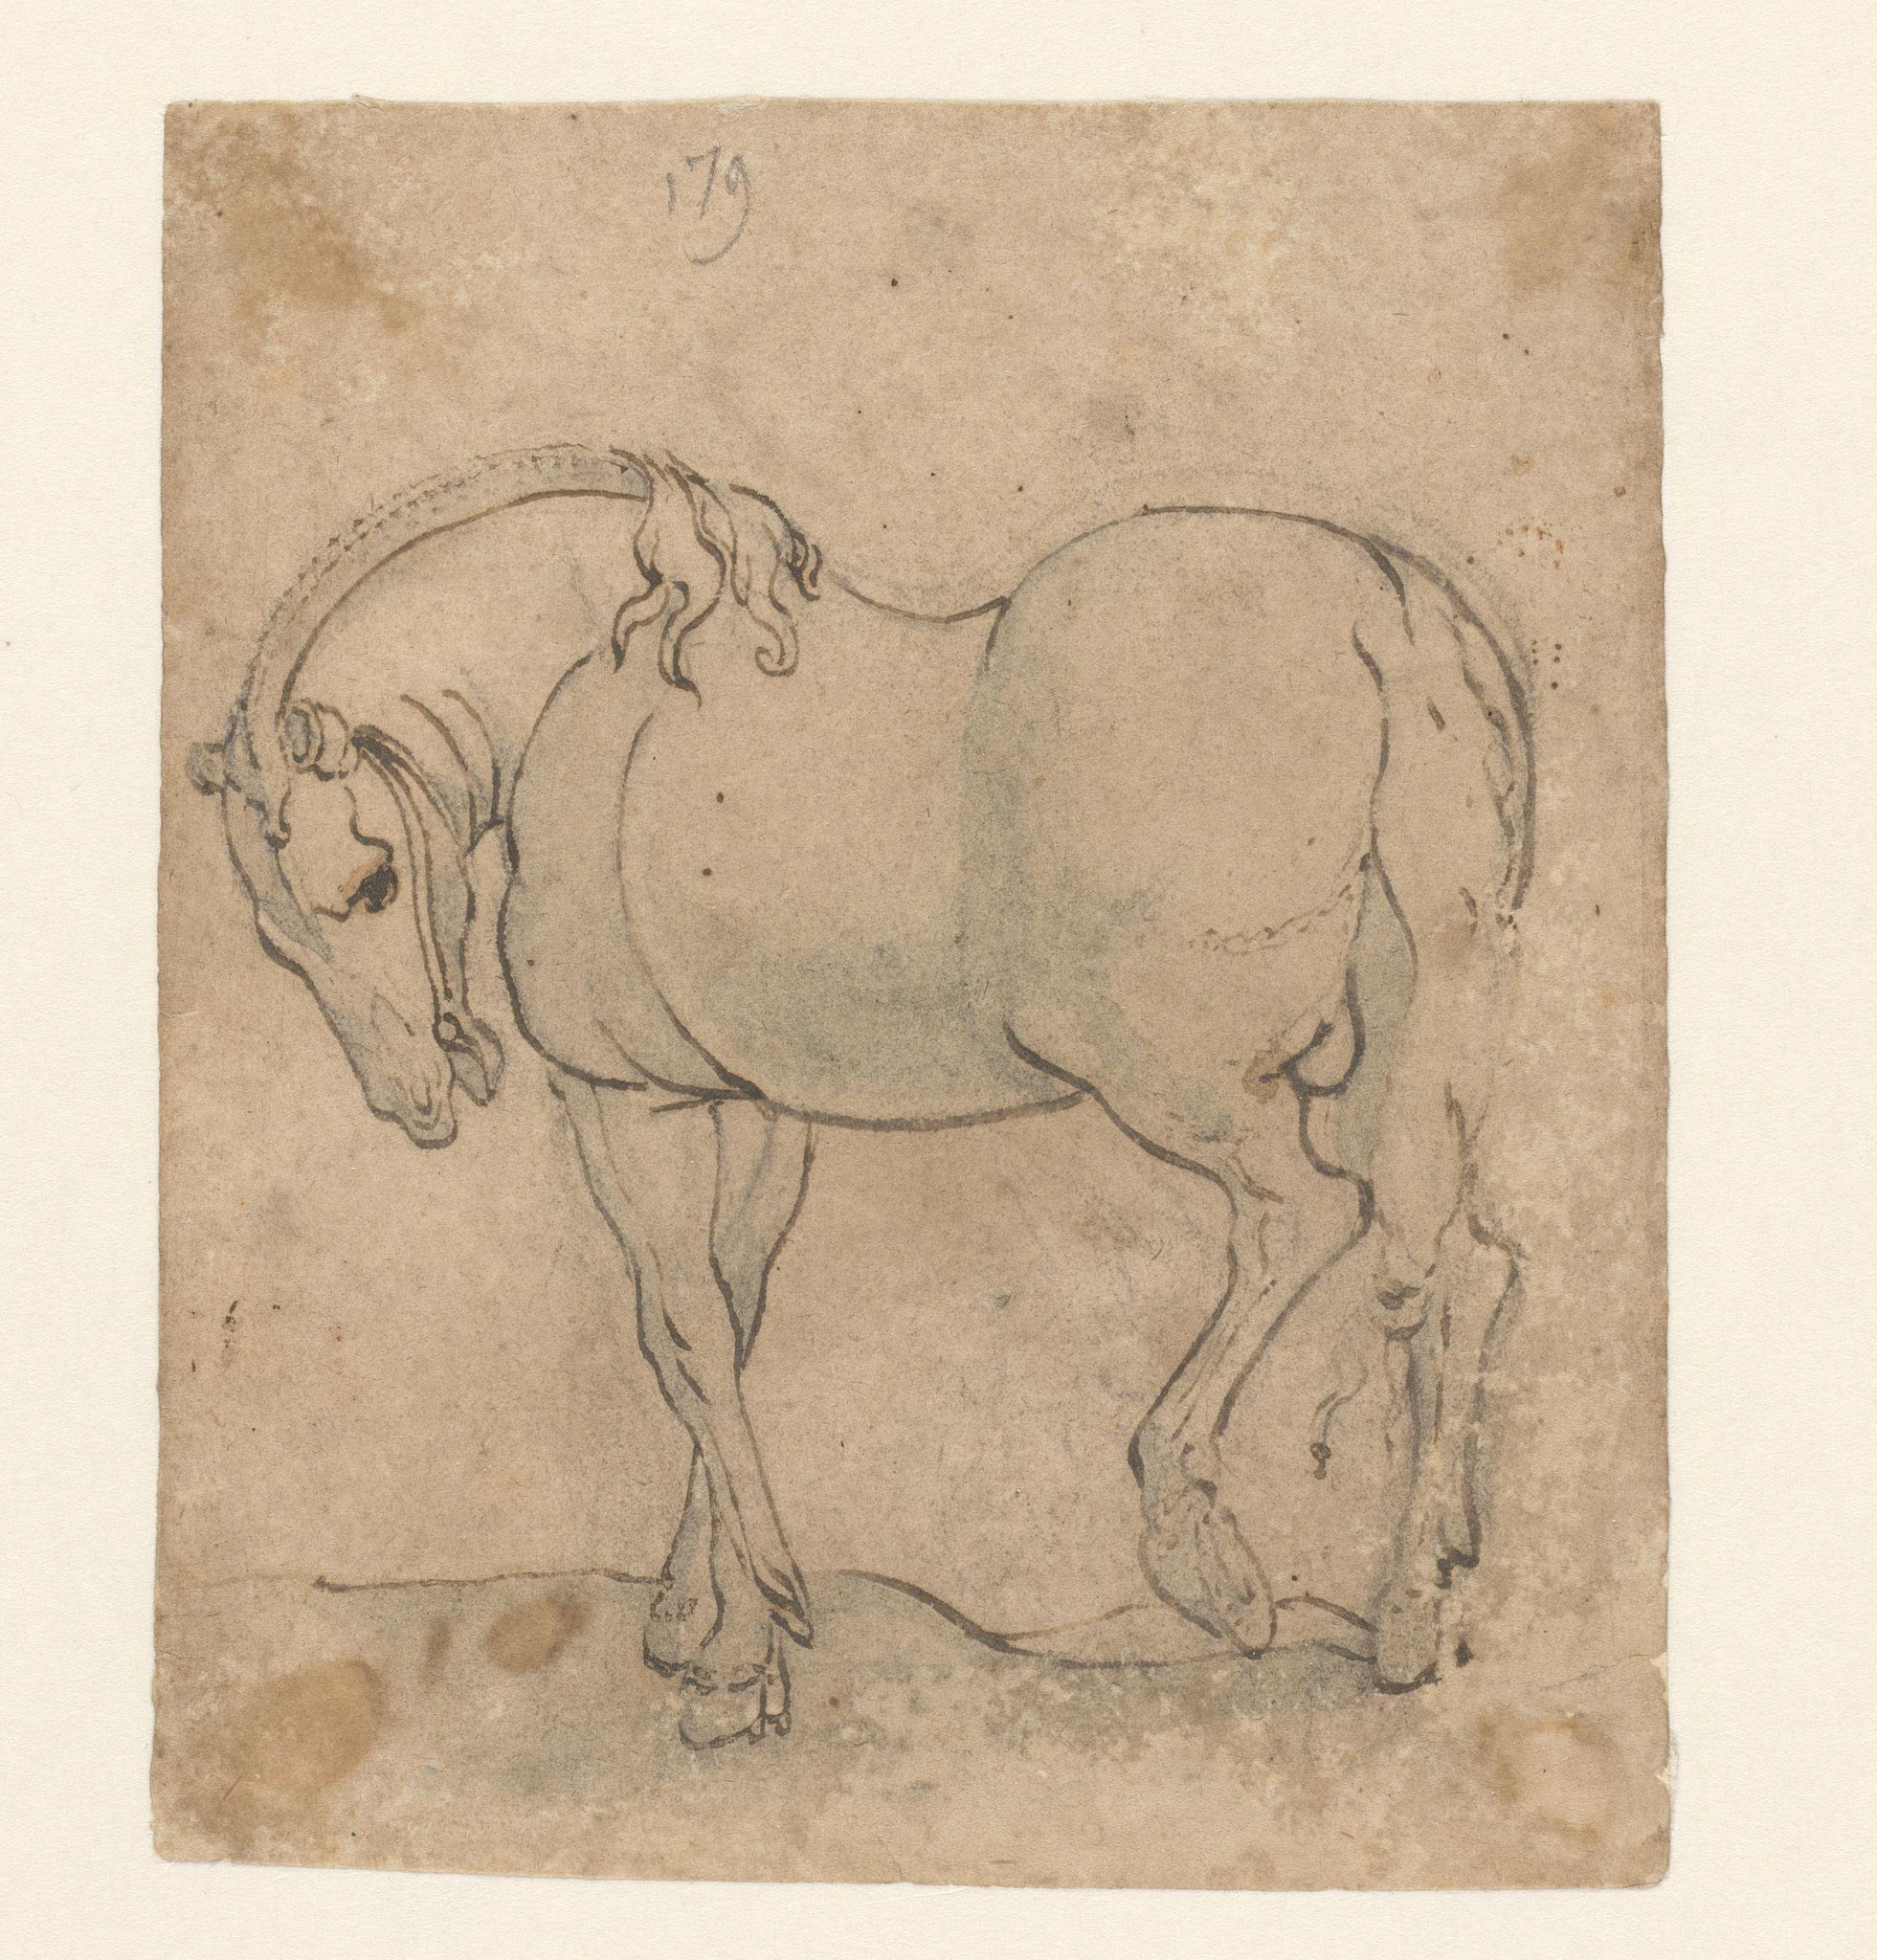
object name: drawing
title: Paard van opzij gezien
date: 1610-1650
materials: ink, paper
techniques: brush, pen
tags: horse